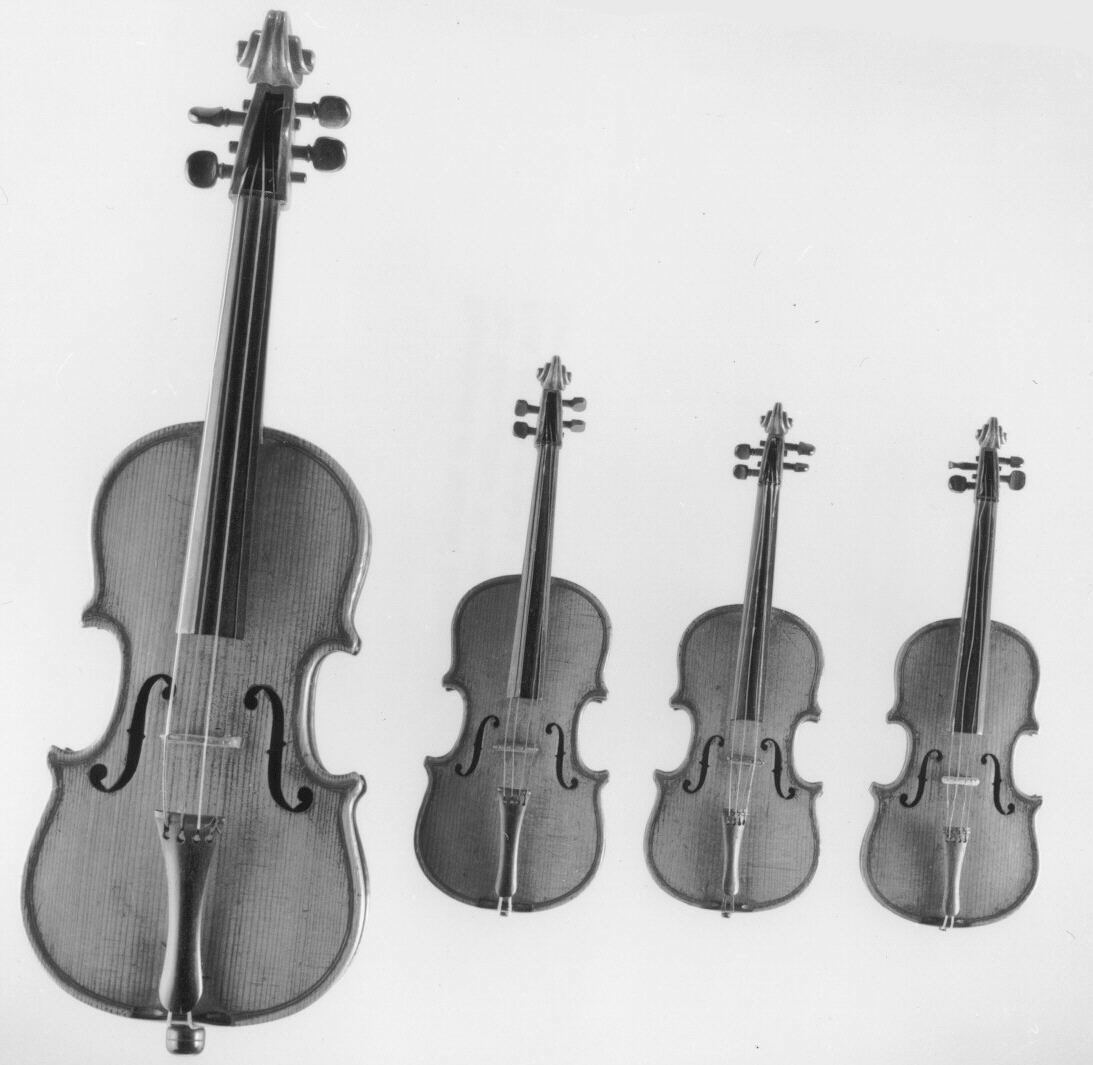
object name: miniature string quartet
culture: european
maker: johannes theodorus cuypers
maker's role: musical instrument maker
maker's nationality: dutch (born germany)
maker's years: 1724-1808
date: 1801-1900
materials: wood